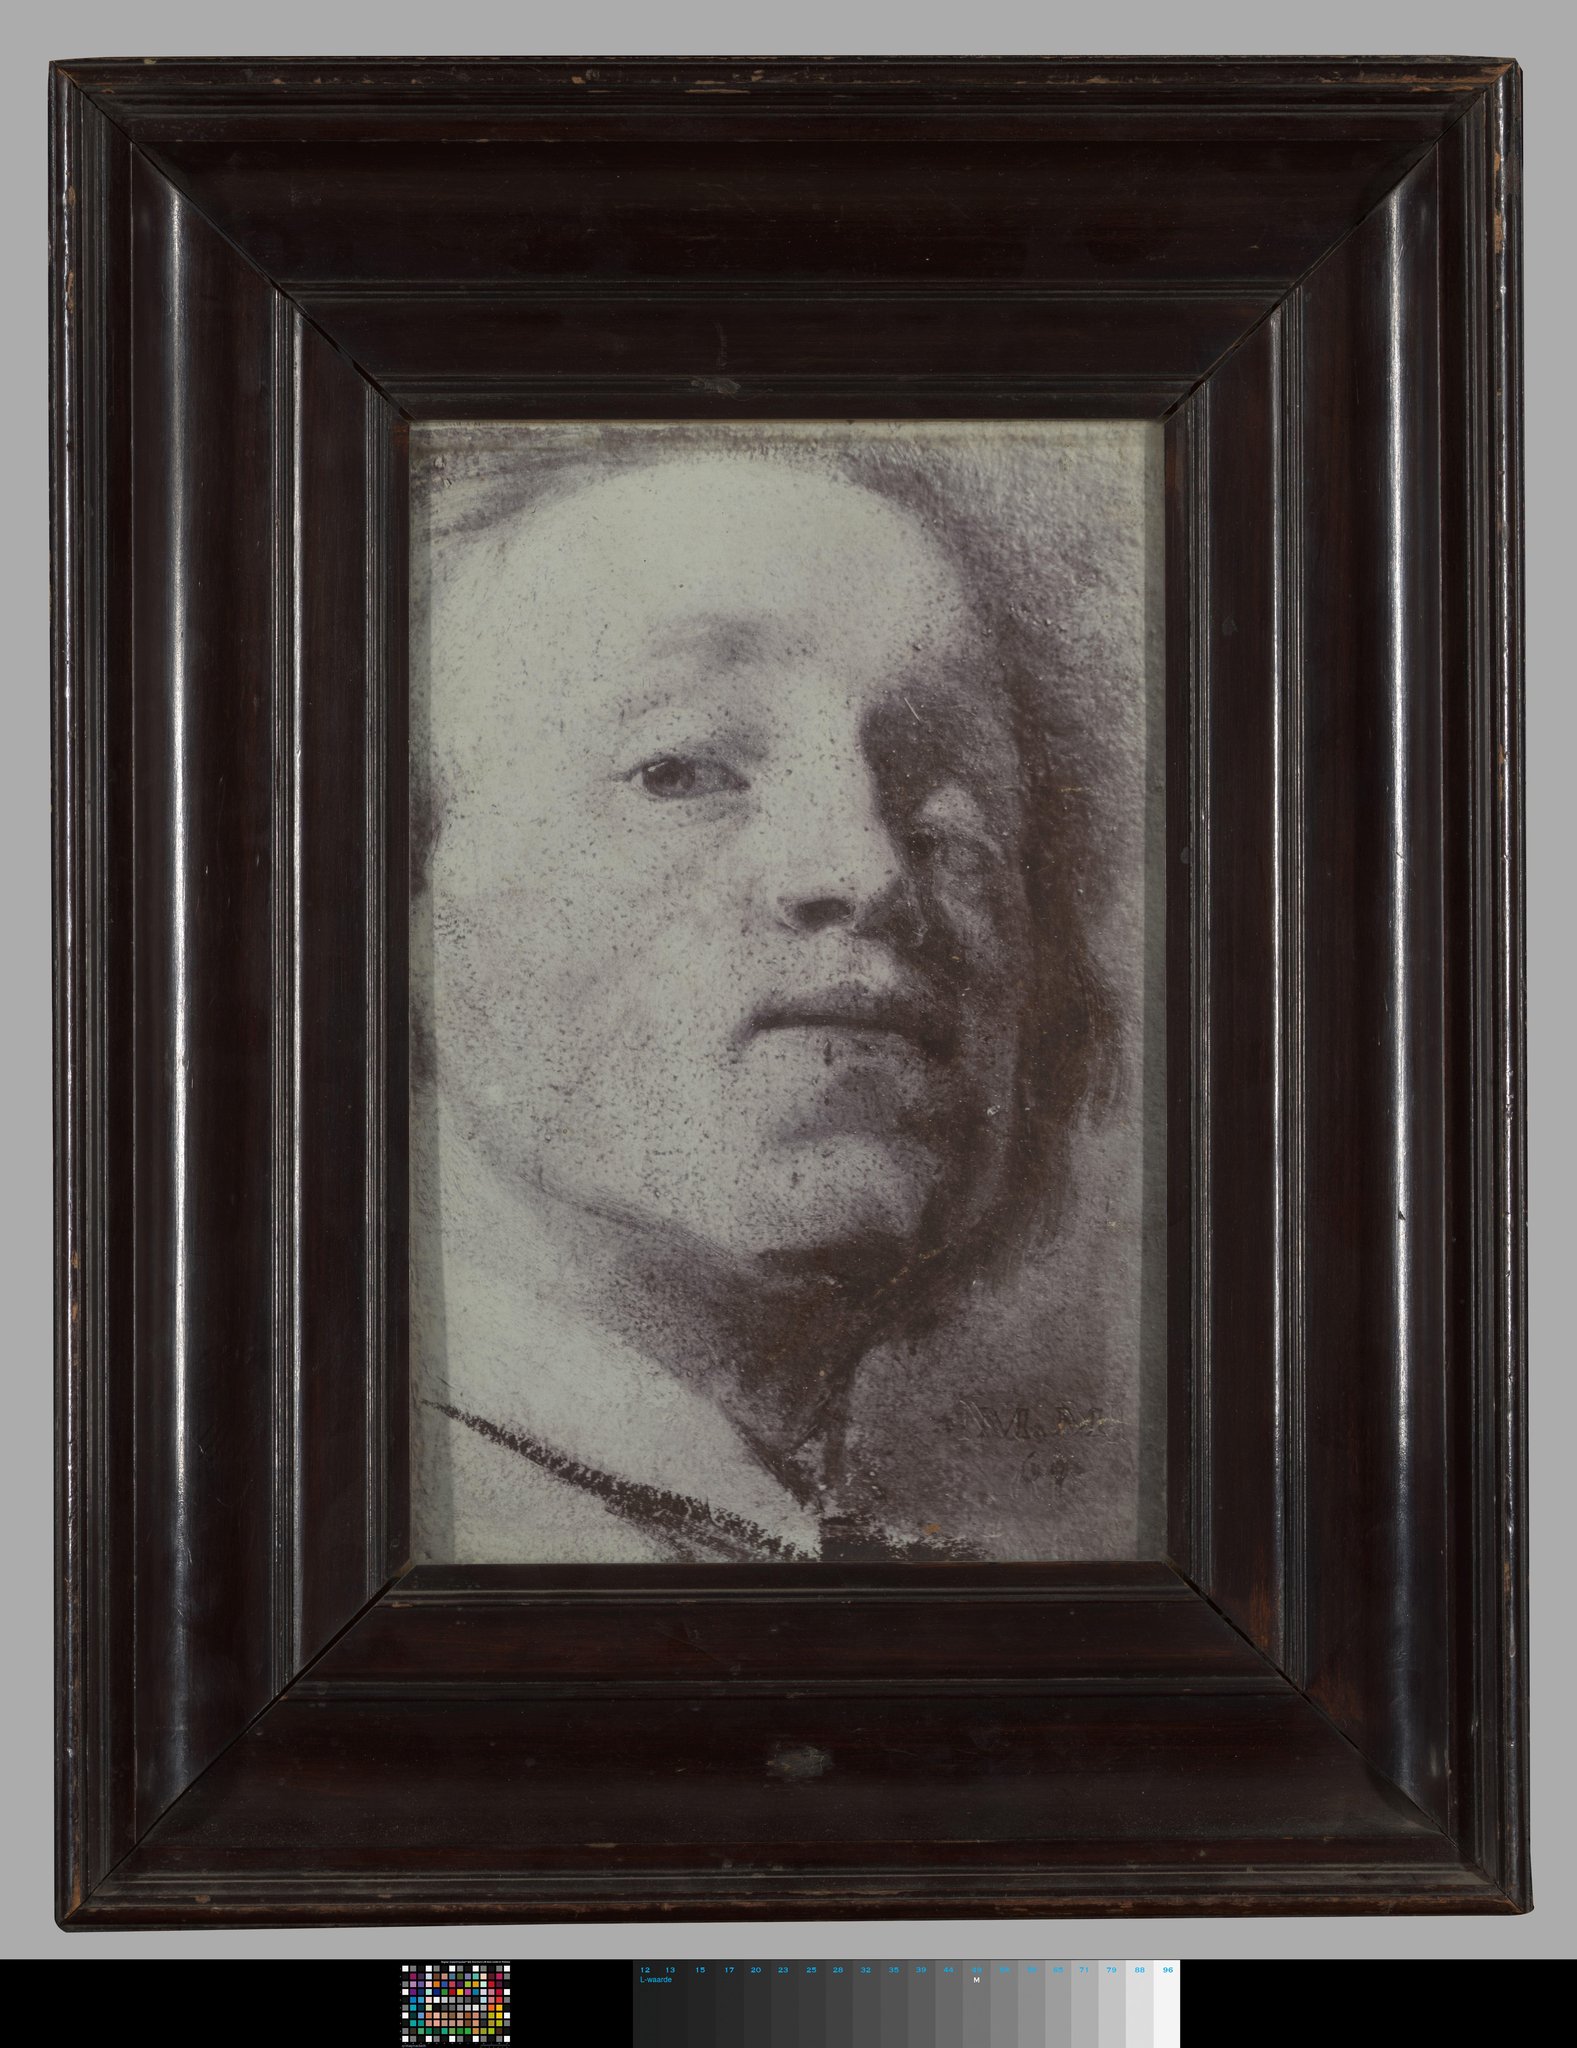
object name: photograph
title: Fotoreproductie van een getekend zelfportret van M.Maris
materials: glass, photographic support, wood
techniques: gelatin silver print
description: Fotoreproductie van een getekend zelfportret van M.Maris. Legaat mevrouw Breitner 1949 (?).